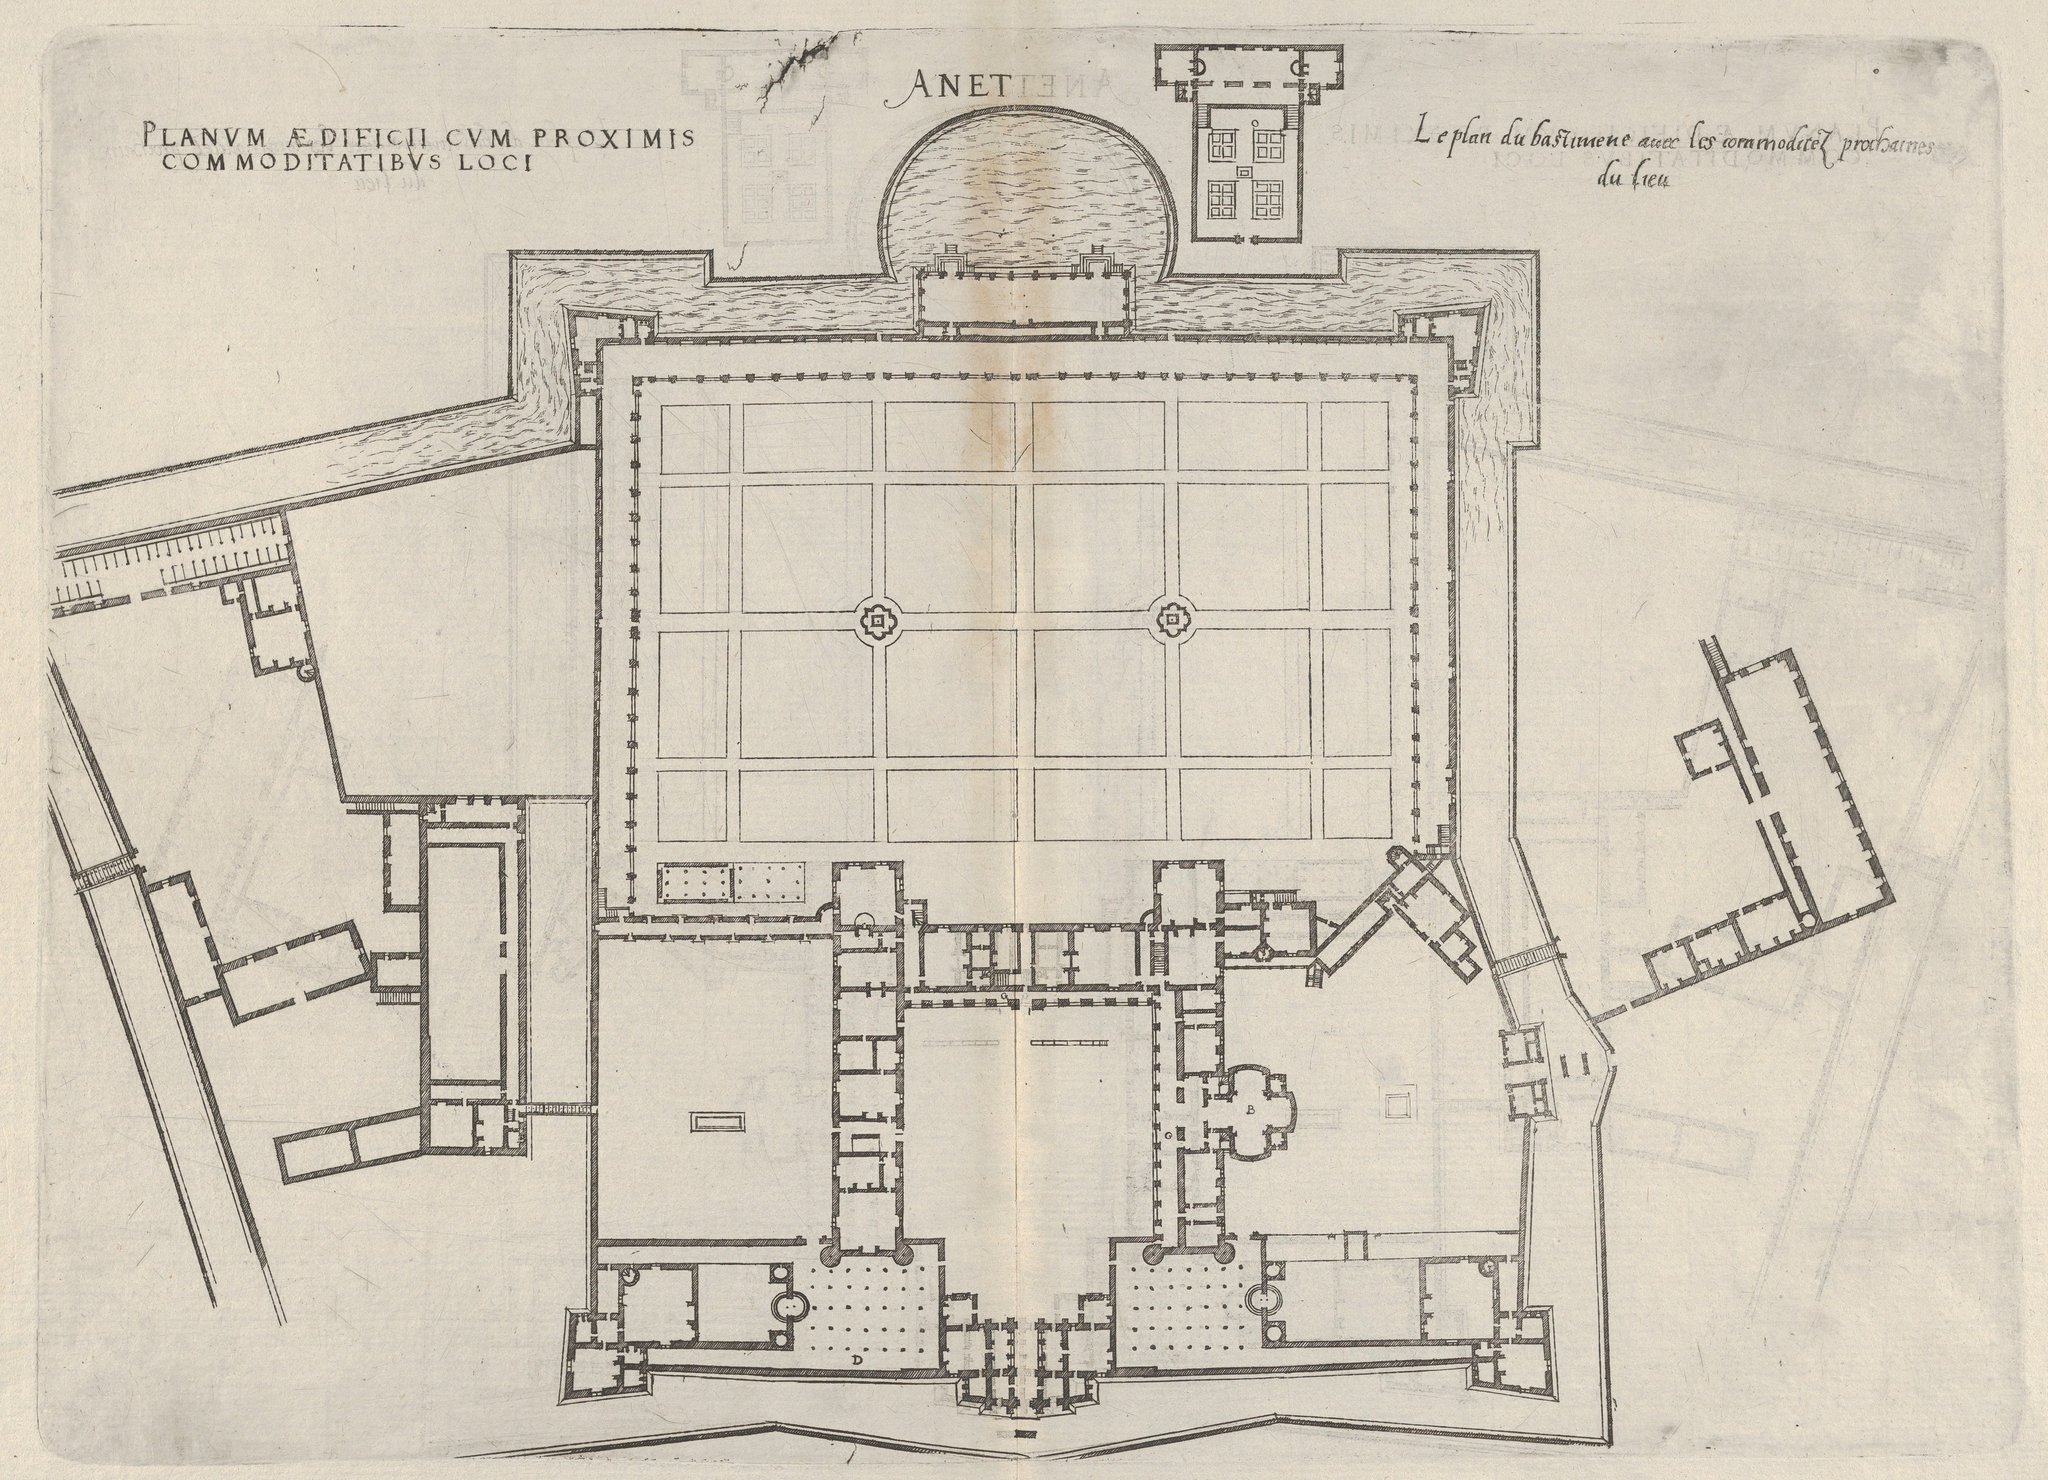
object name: print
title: Floorplan of Chateau d'Anet, from "Les plus excellents bastiments de France"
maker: jacques androuet du cerceau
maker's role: artist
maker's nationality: french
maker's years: 1510-1585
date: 1607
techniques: engraving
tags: architecture